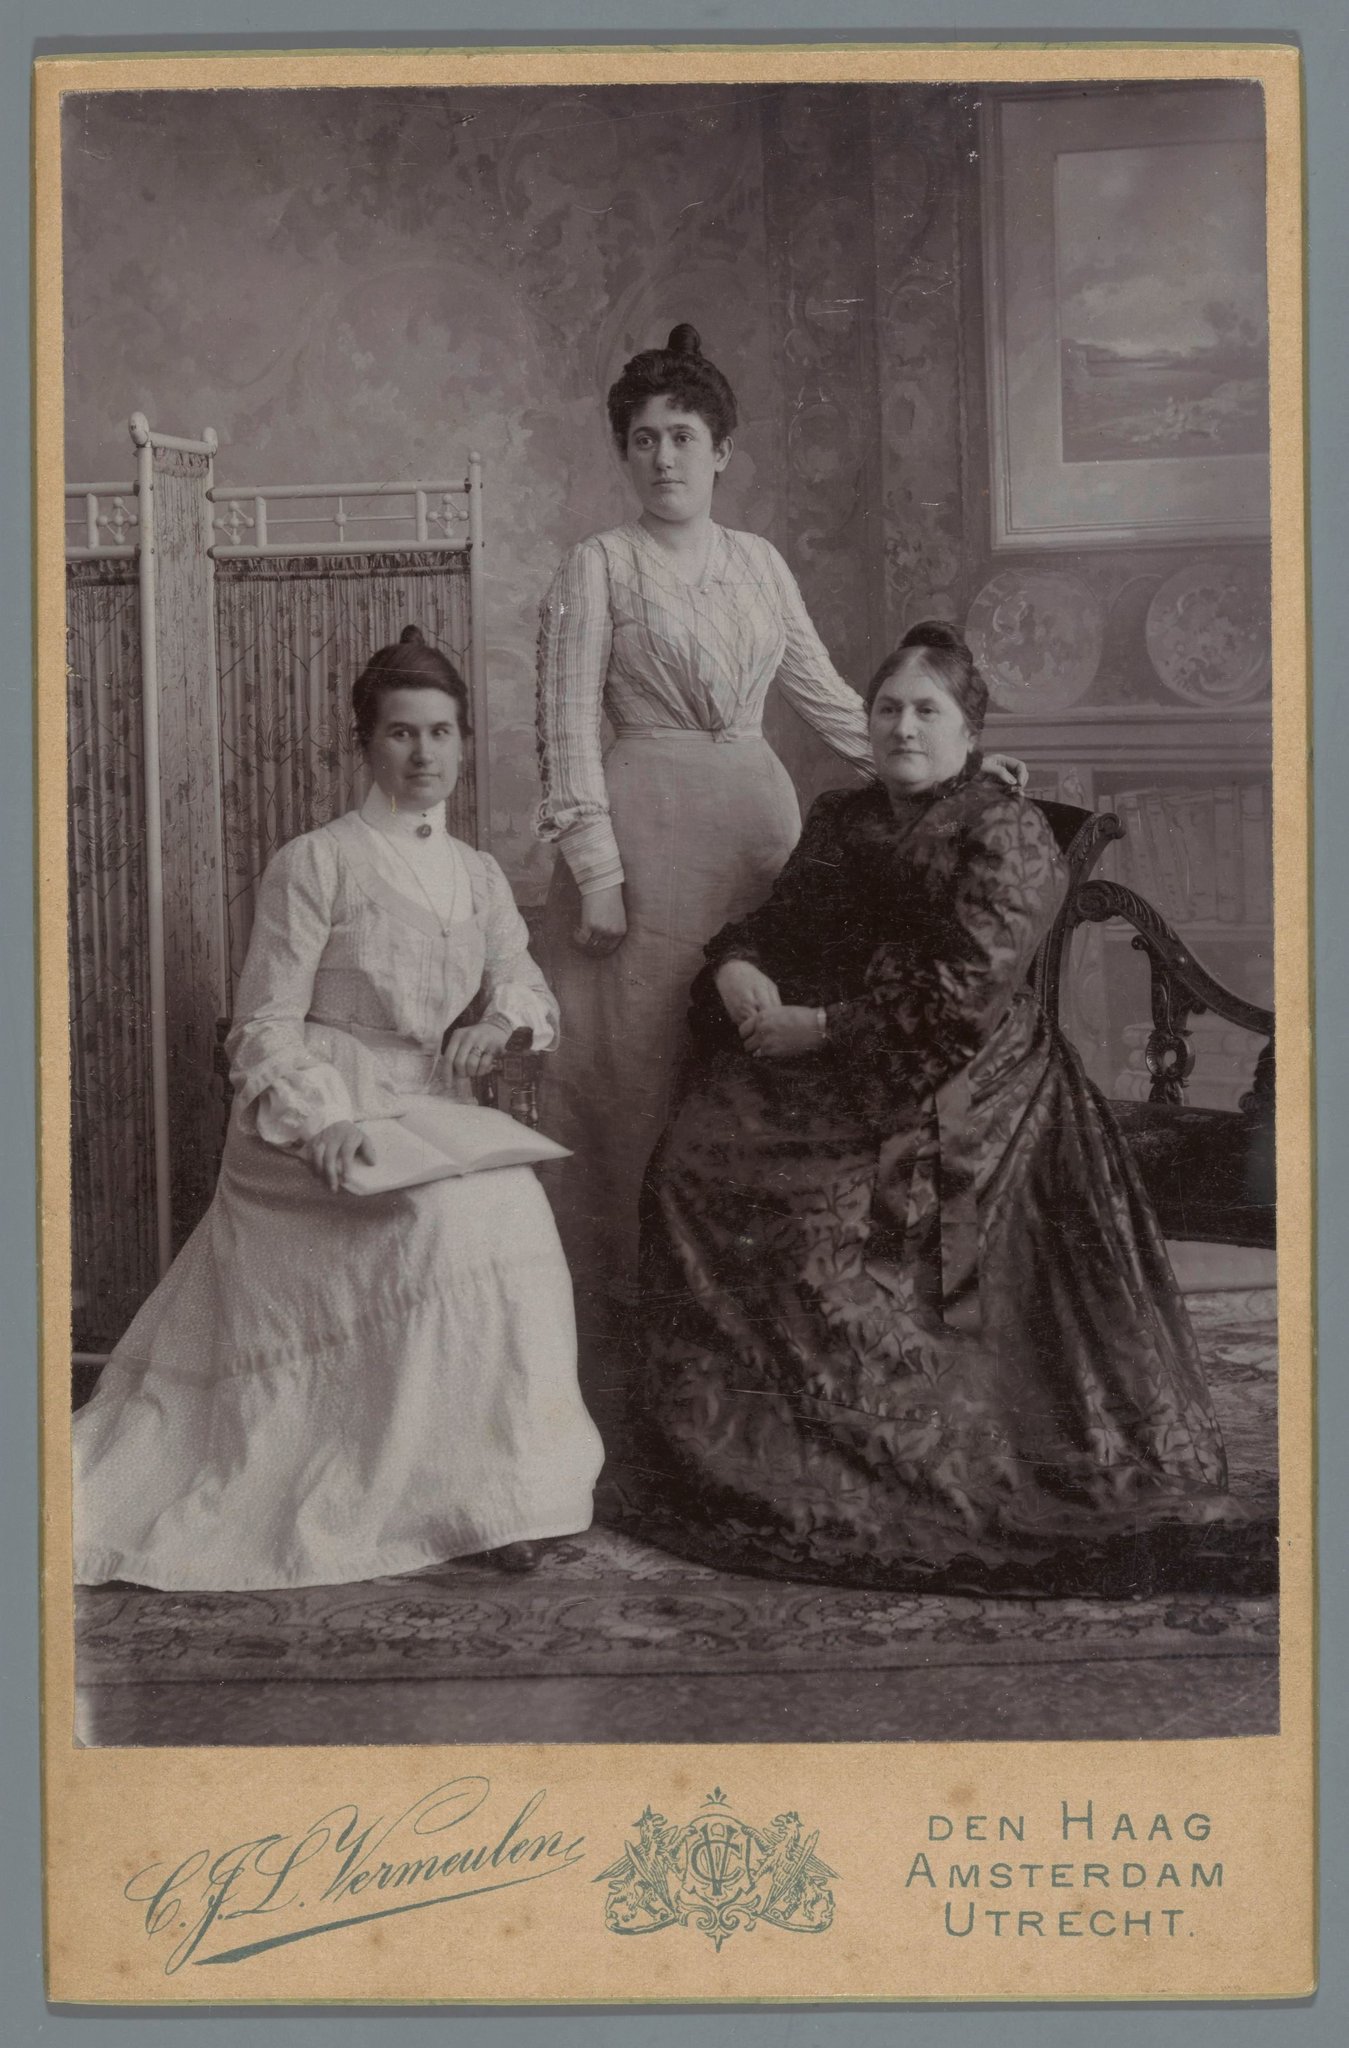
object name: cabinet photograph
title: Studioportret van drie onbekende vrouwen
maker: cornelis johannes lodewicus vermeulen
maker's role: fotograaf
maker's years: 1861-1936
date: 1890-1910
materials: cardboard, photographic support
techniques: collodion silver print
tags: studio ~ photographer, mother and daughter(s) (family group)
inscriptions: inscription: ‘C.J.L. Vermeulen (...) Telephoon No. 750.’